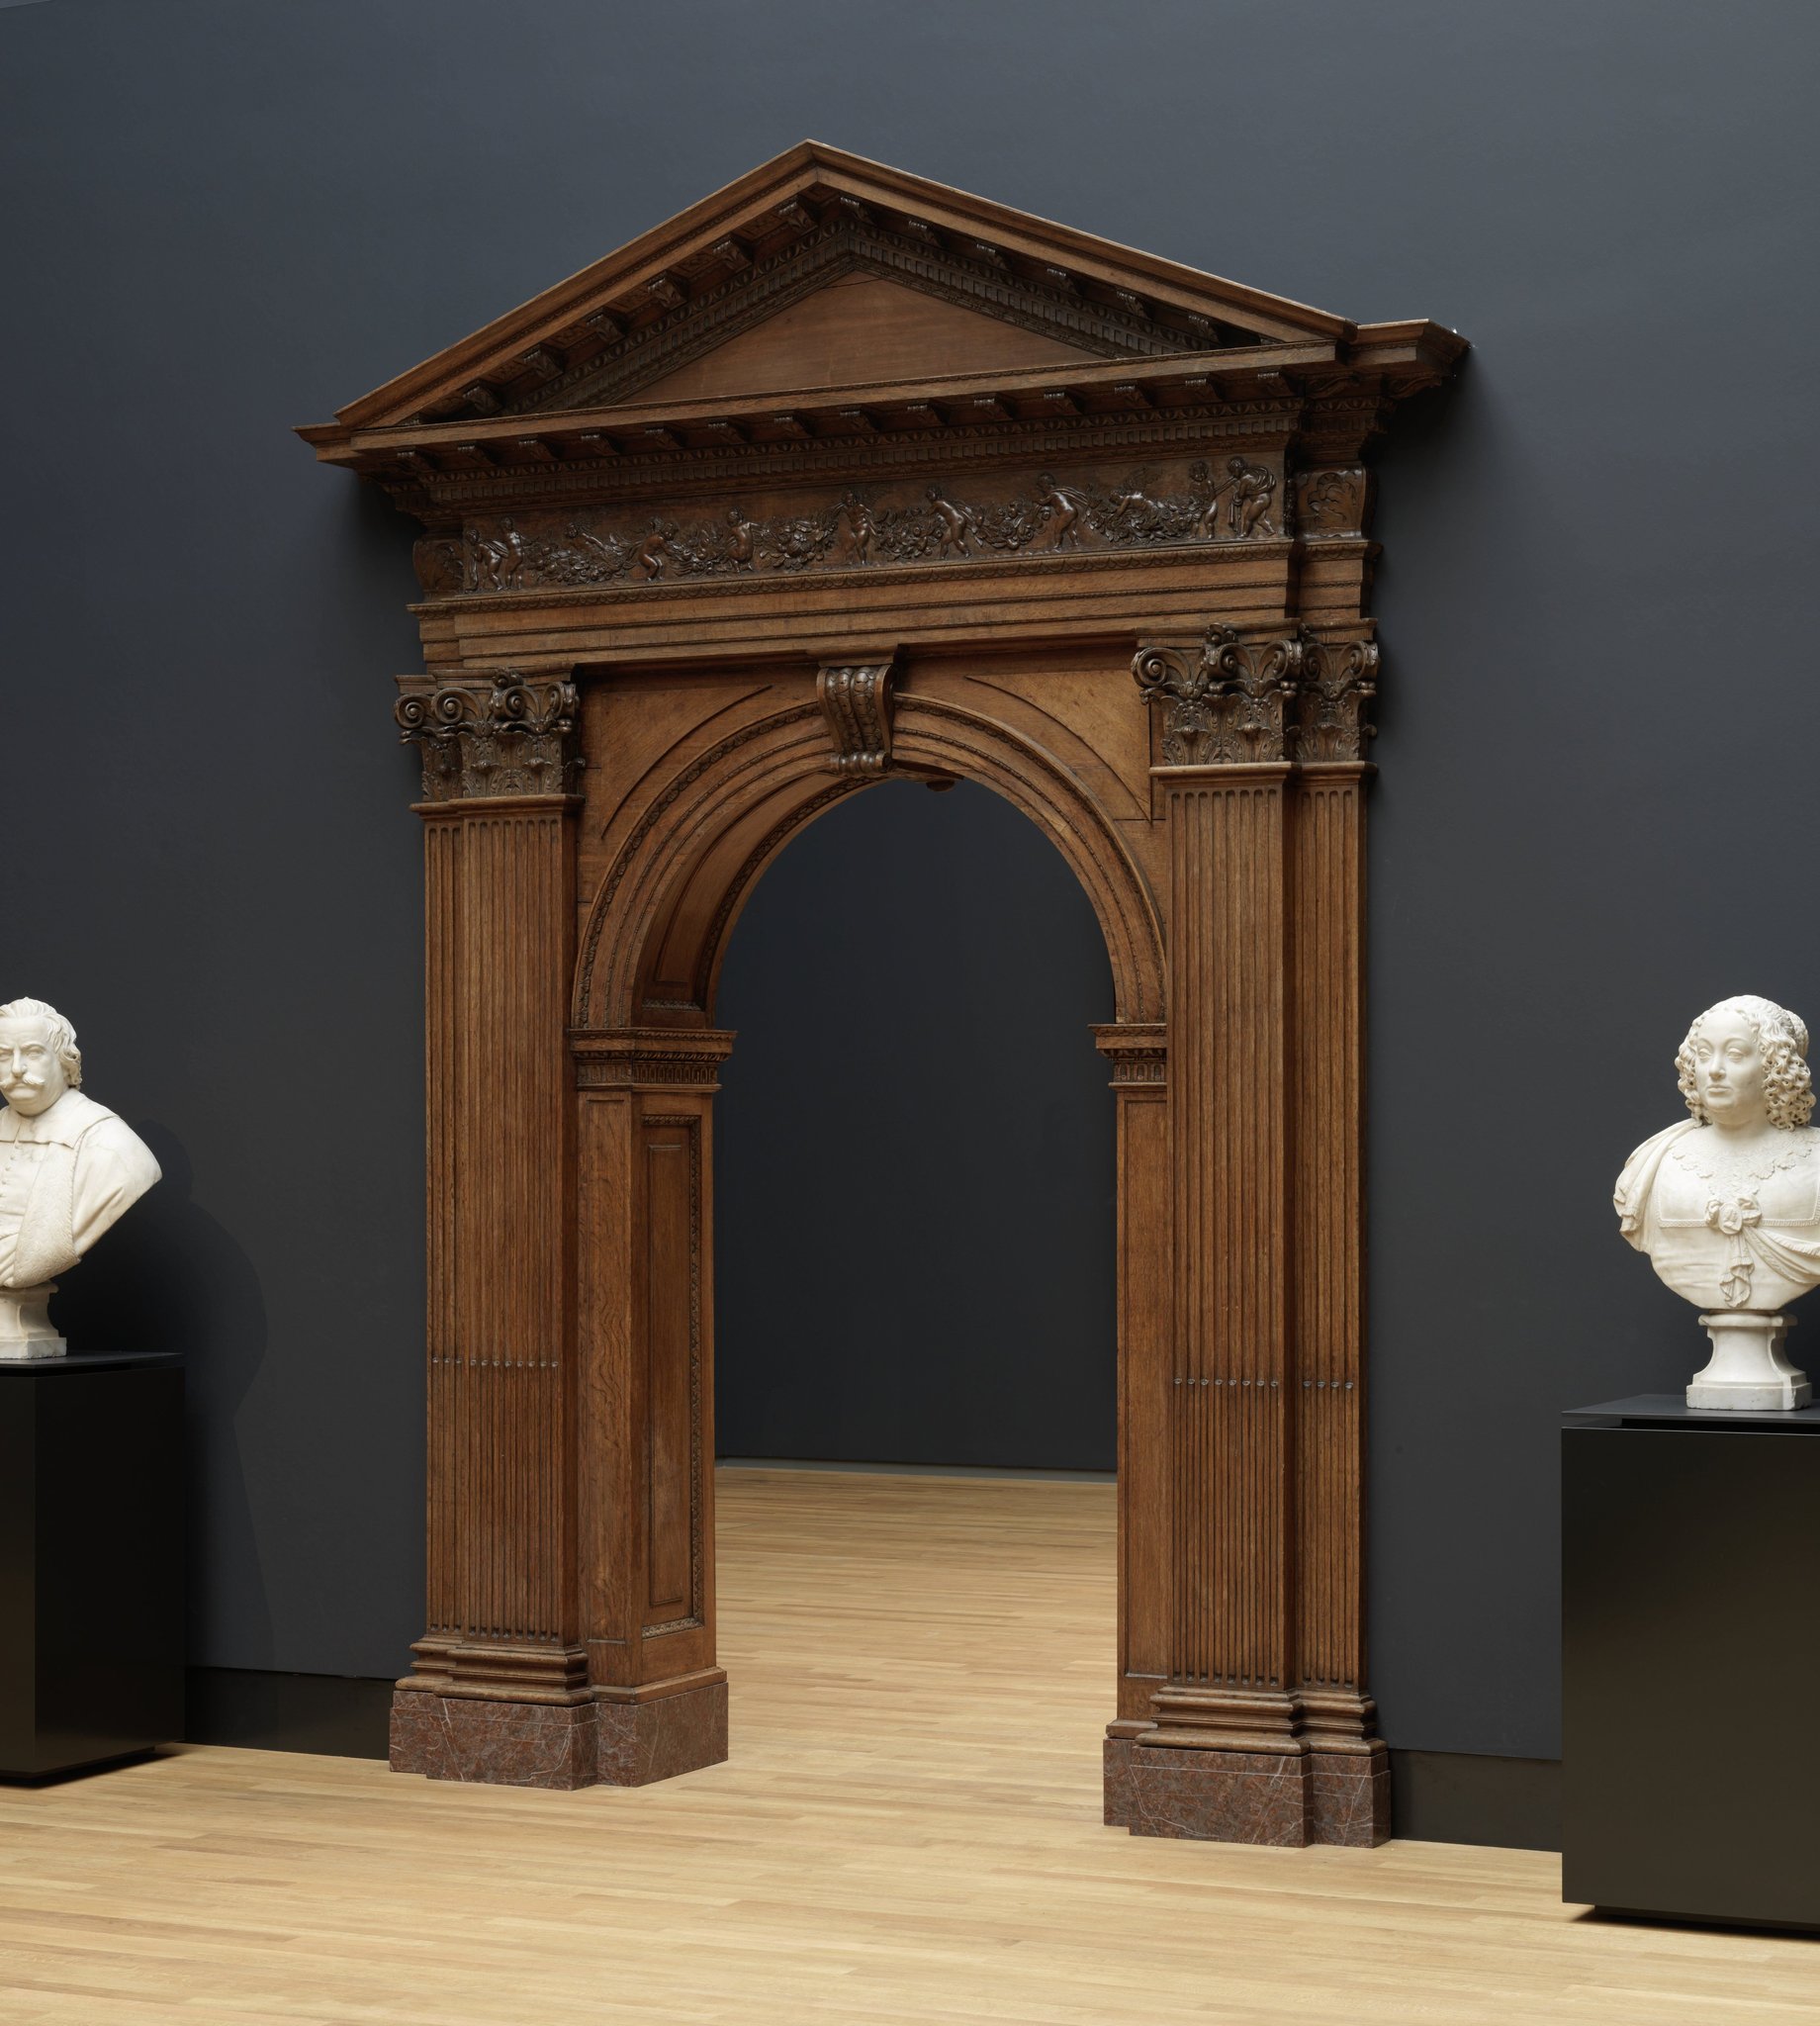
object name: relief sculpture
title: Portico and pediment from the Huydecoper house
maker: philips vinckboons (ii)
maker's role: draughtsman, painter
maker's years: 1607-1678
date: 1639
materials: wood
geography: northern netherlands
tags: amsterdam, mayor, joan huydecoper van maarseveen (i), half-column, pilaster ~ architecture, ornament ~ festoon, garland, cupids: 'amores', 'amoretti', 'putti'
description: This portico is from the entrance hall of a grand house on the Singel canal in Amsterdam, designed by the architect Vinckboons in 1639. Both the exterior and the interior of the building were classicizing in style. The house was commissioned by Joan Huydecoper, mayor of Amsterdam and a prominent art lover.